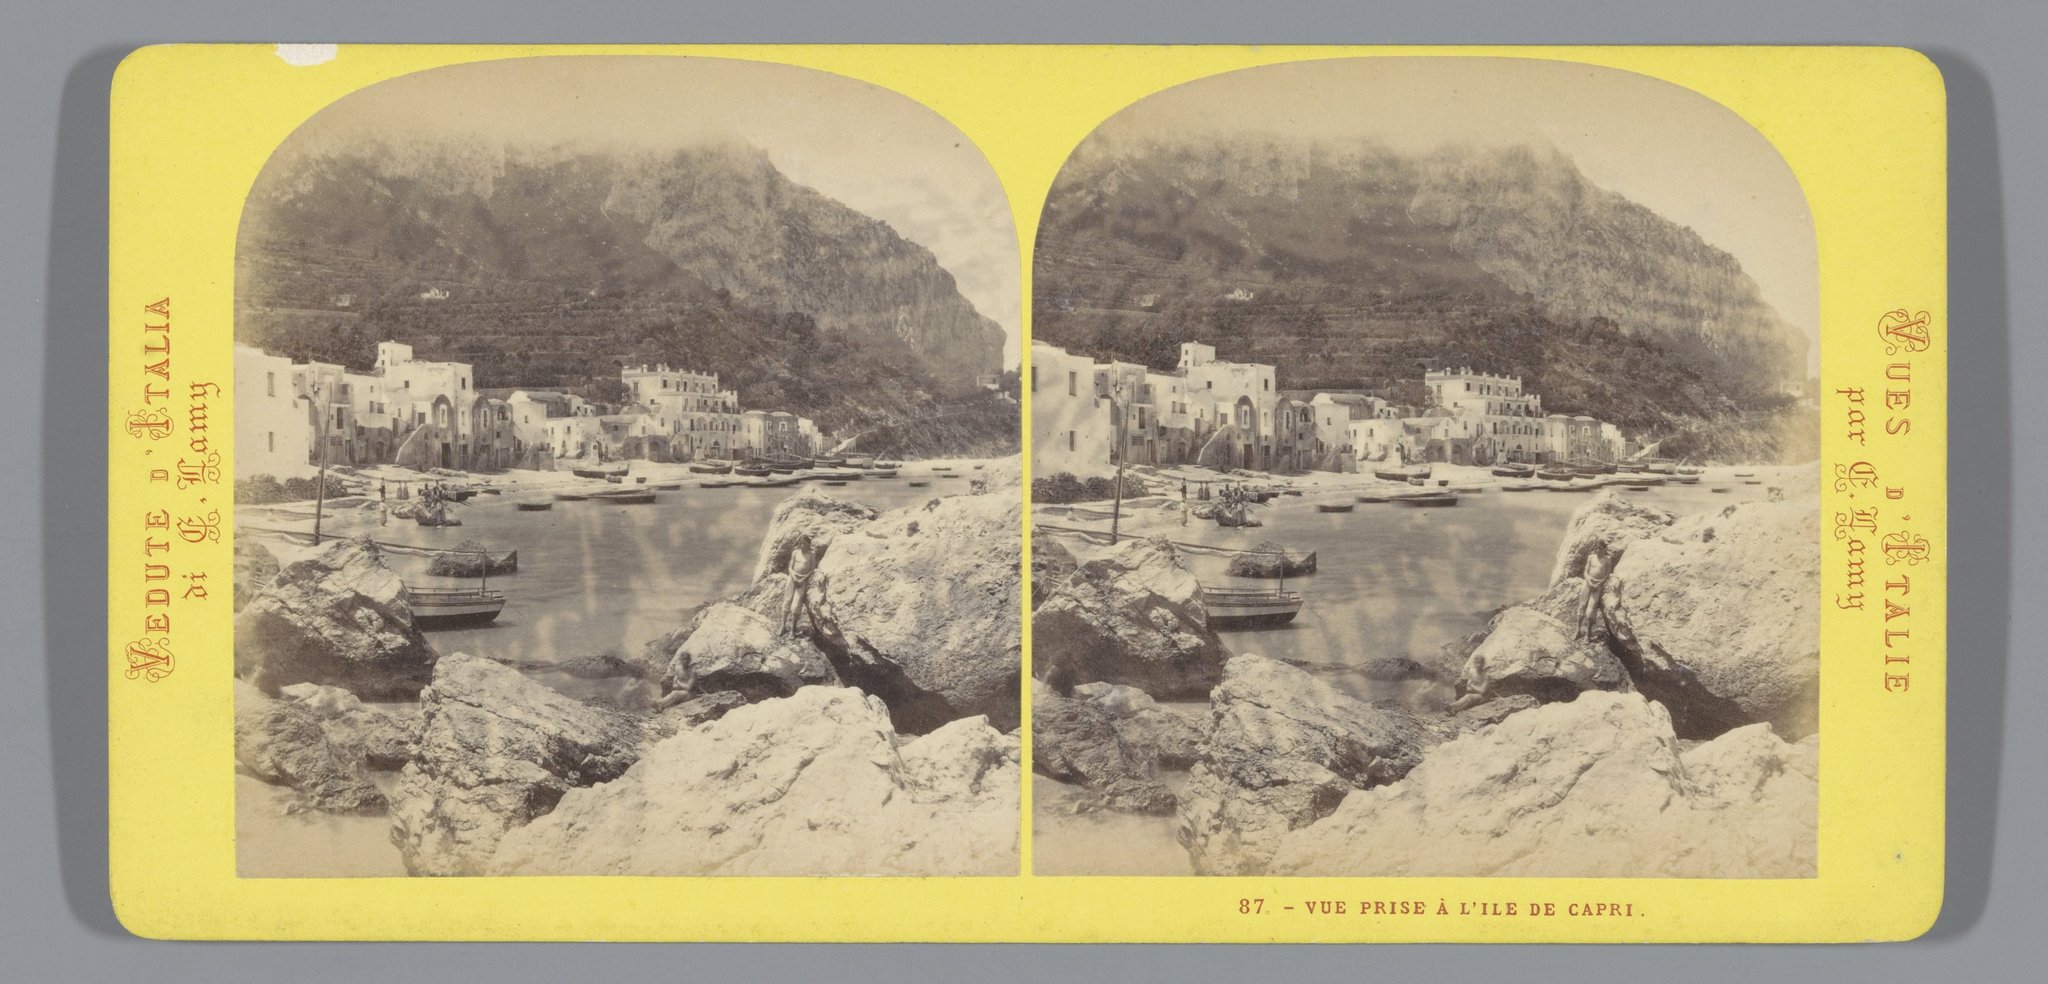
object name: stereograph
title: Kust bij Marina Piccola, Capri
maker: ernest eléonor pierre lamy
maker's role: publisher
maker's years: 1828-1900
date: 1861-1878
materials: cardboard, paper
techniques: albumen print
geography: marina piccola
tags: beach (as place of recreation), gulf, bay, coast, beach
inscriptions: number: ‘87.’